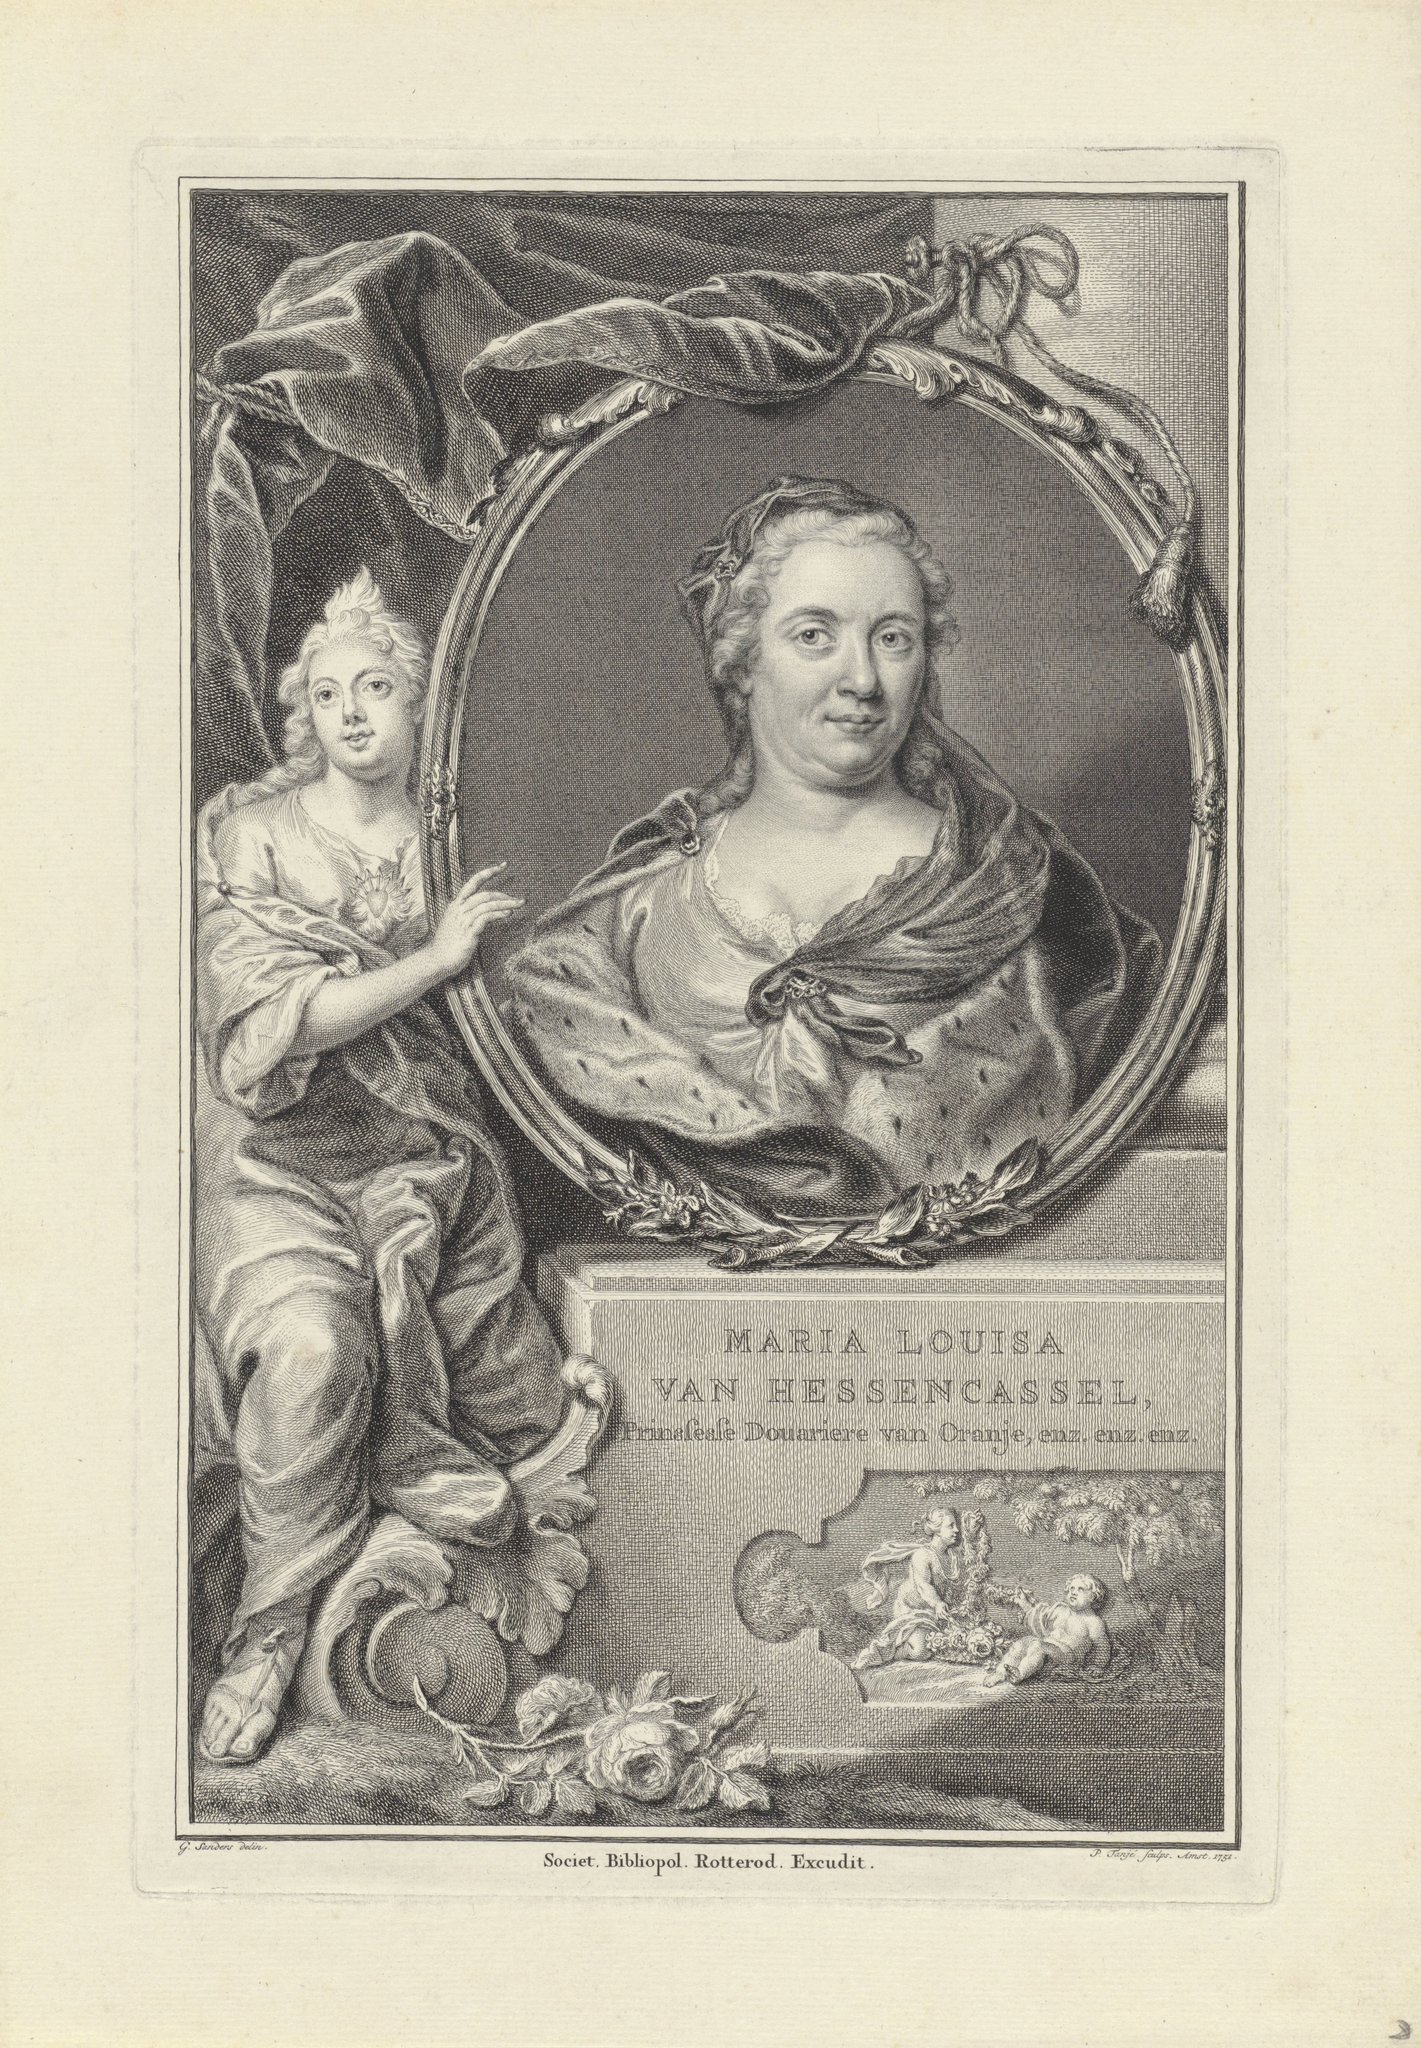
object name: print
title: Portret van prinses Maria Louise van Oranje-Nassau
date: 1751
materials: paper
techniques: engraving, etching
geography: amsterdam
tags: heart symbolism - aa - female human figure, flowers: rose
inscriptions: collector's mark: Lugt 2228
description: Portret van Maria Louise, prinses van Oranje-Nassau, gekleed in hermelijnen mantel, met een sluier op het hoofd. Zij was de vrouw van prins Johan Willem Friso van Oranje-Nassau en werd na krap twee jaar huwelijk al weduwe. Een vrouw met een met pijlen doorboord hart toont het ovale portret. Het reliëf op het basement toont twee spelende putti met rozenguirlandes.